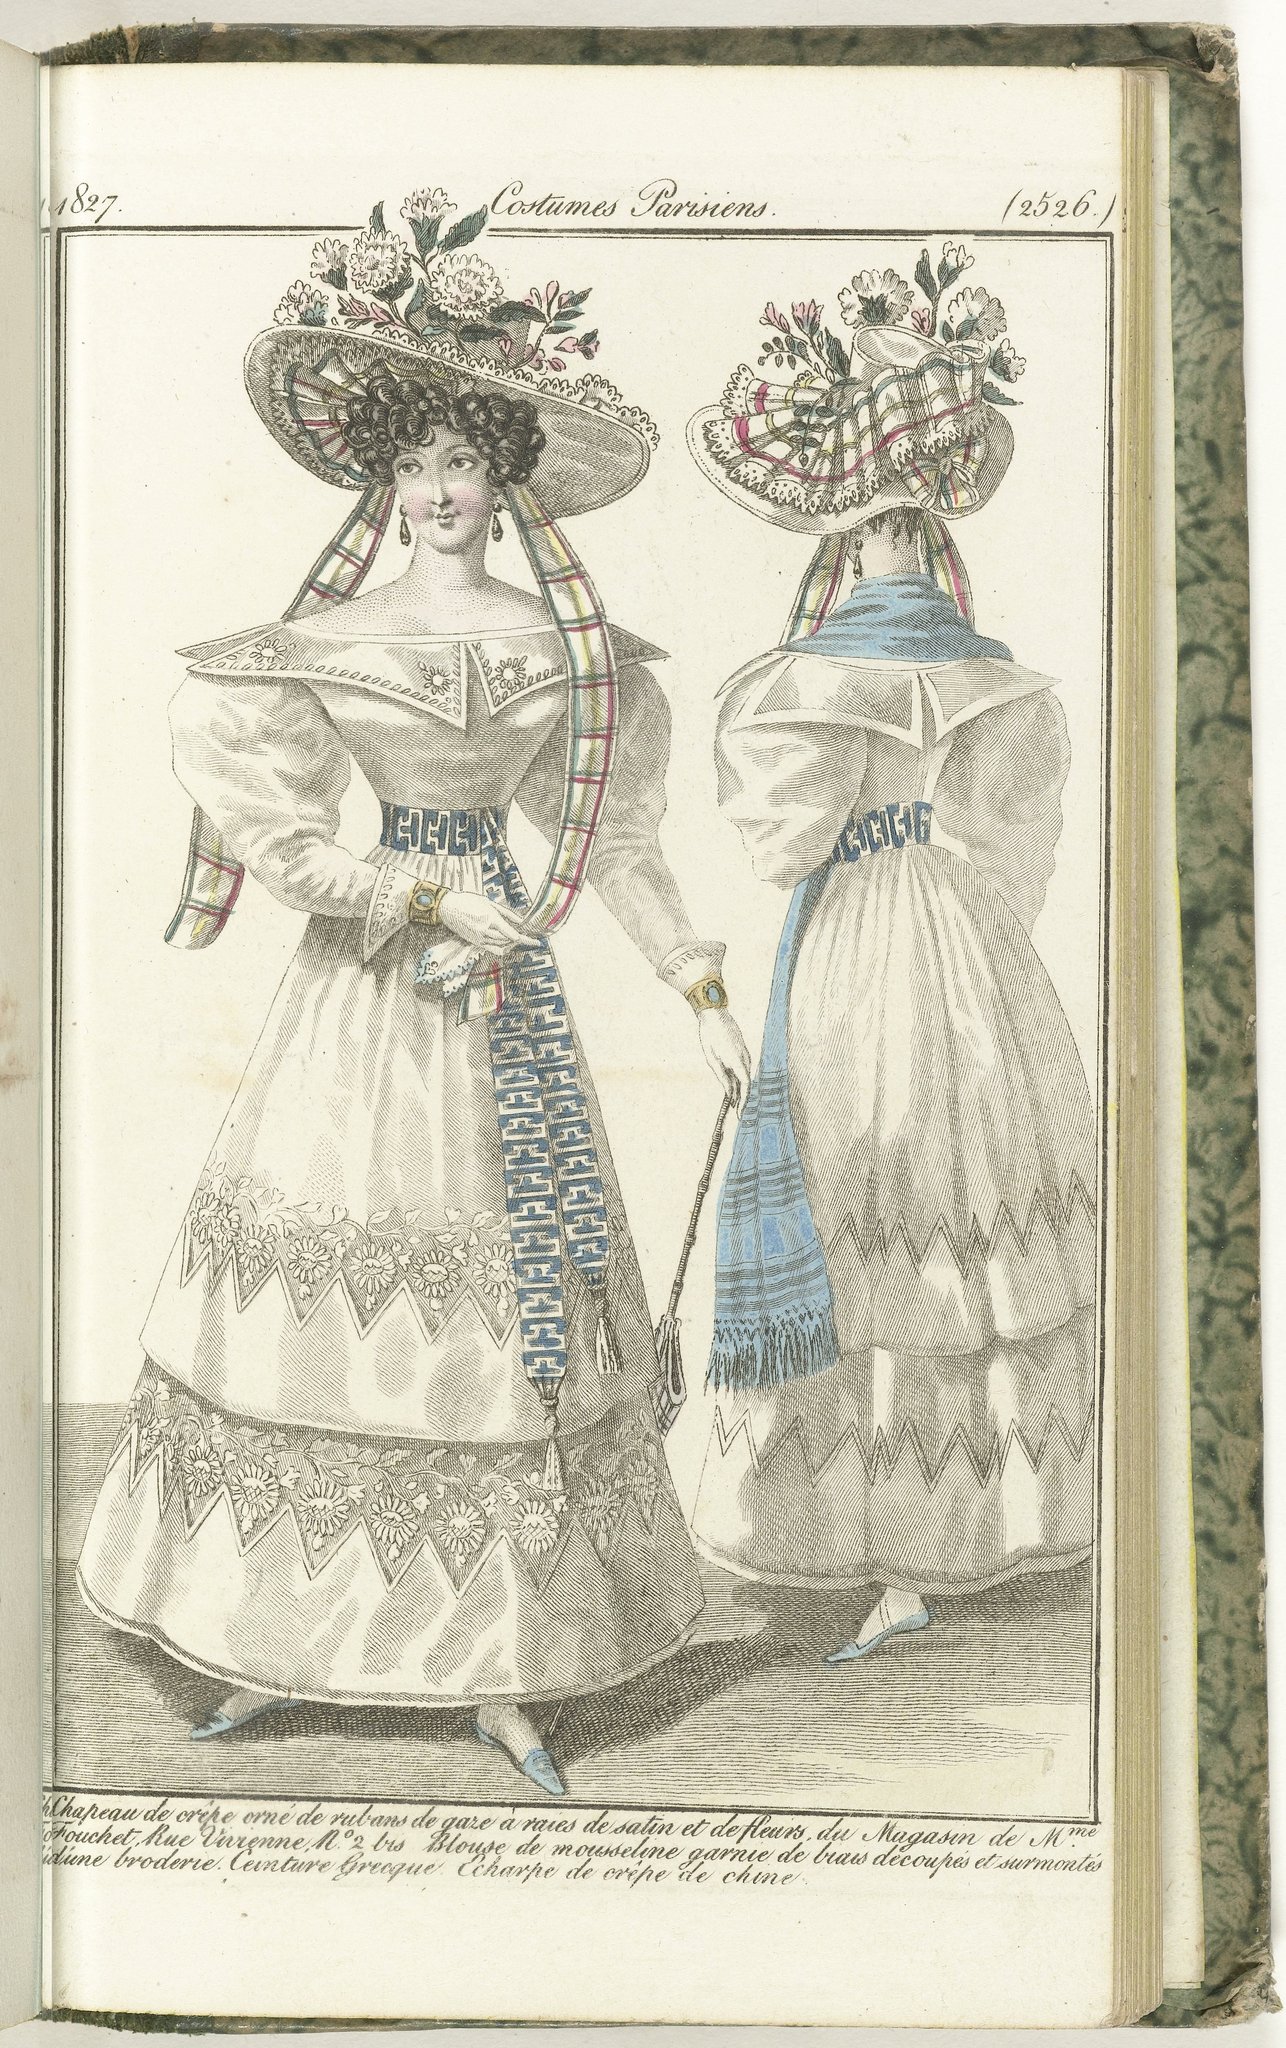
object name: fashion print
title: Journal des Dames et des Modes, Costumes Parisiens, 15 août 1827, (2526) : Chapeau de crêpe...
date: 1827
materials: paper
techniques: engraving, hand coloring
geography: paris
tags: clothing for the upper part of the body (shawl) (+ women's clothes), walking-stick, staff, cane (+ women's clothes), border, ribbon, braid (+ women's clothes), clothing for the upper part of the body: blouse (+ women's clothes), fashion plates, head-gear: hat (+ women's clothes), bracelet, wristlet (+ women's clothes), belt, girdle, waistband (+ women's clothes)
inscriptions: title: ‘Costumes Parisiens’, caption: ‘Chapeau de crêpe orné de rubans de gaze à raies de satin et de fleurs, du Magasin de Mme. Fouchet, Rue Vivienne, No. 2 bis. Blouse de mousseline garnie de biais découpés et surmontés d'une broderie. ceinture grecque. Echarpe de crêpe de Chine.’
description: 'Blouse' van mousseline versierd met een 'biais découpés et surmontés d'une broderie'. Op het hoofd een hoed van crêpe versierd met bloemen en linten van tule met satijnen strepen, uit de winkel van Fouchet. 'Ceinture grecque' en een sjaal van 'crêpe de Chine'. Verdere accessoires: oorbellen, handschoenen, parasol, platte schoenen. Figuur in eenzelfde ensemble, op de rug gezien. De prent maakt deel uit van het modetijdschrift Journal des Dames et des Modes, uitgegeven door Pierre de la Mésangère, Parijs, 1797-1839. Ingebonden met Le Petit Courrier des Dames. 15 Januari 1827 t/m 20 maart 1830. Incompleet.